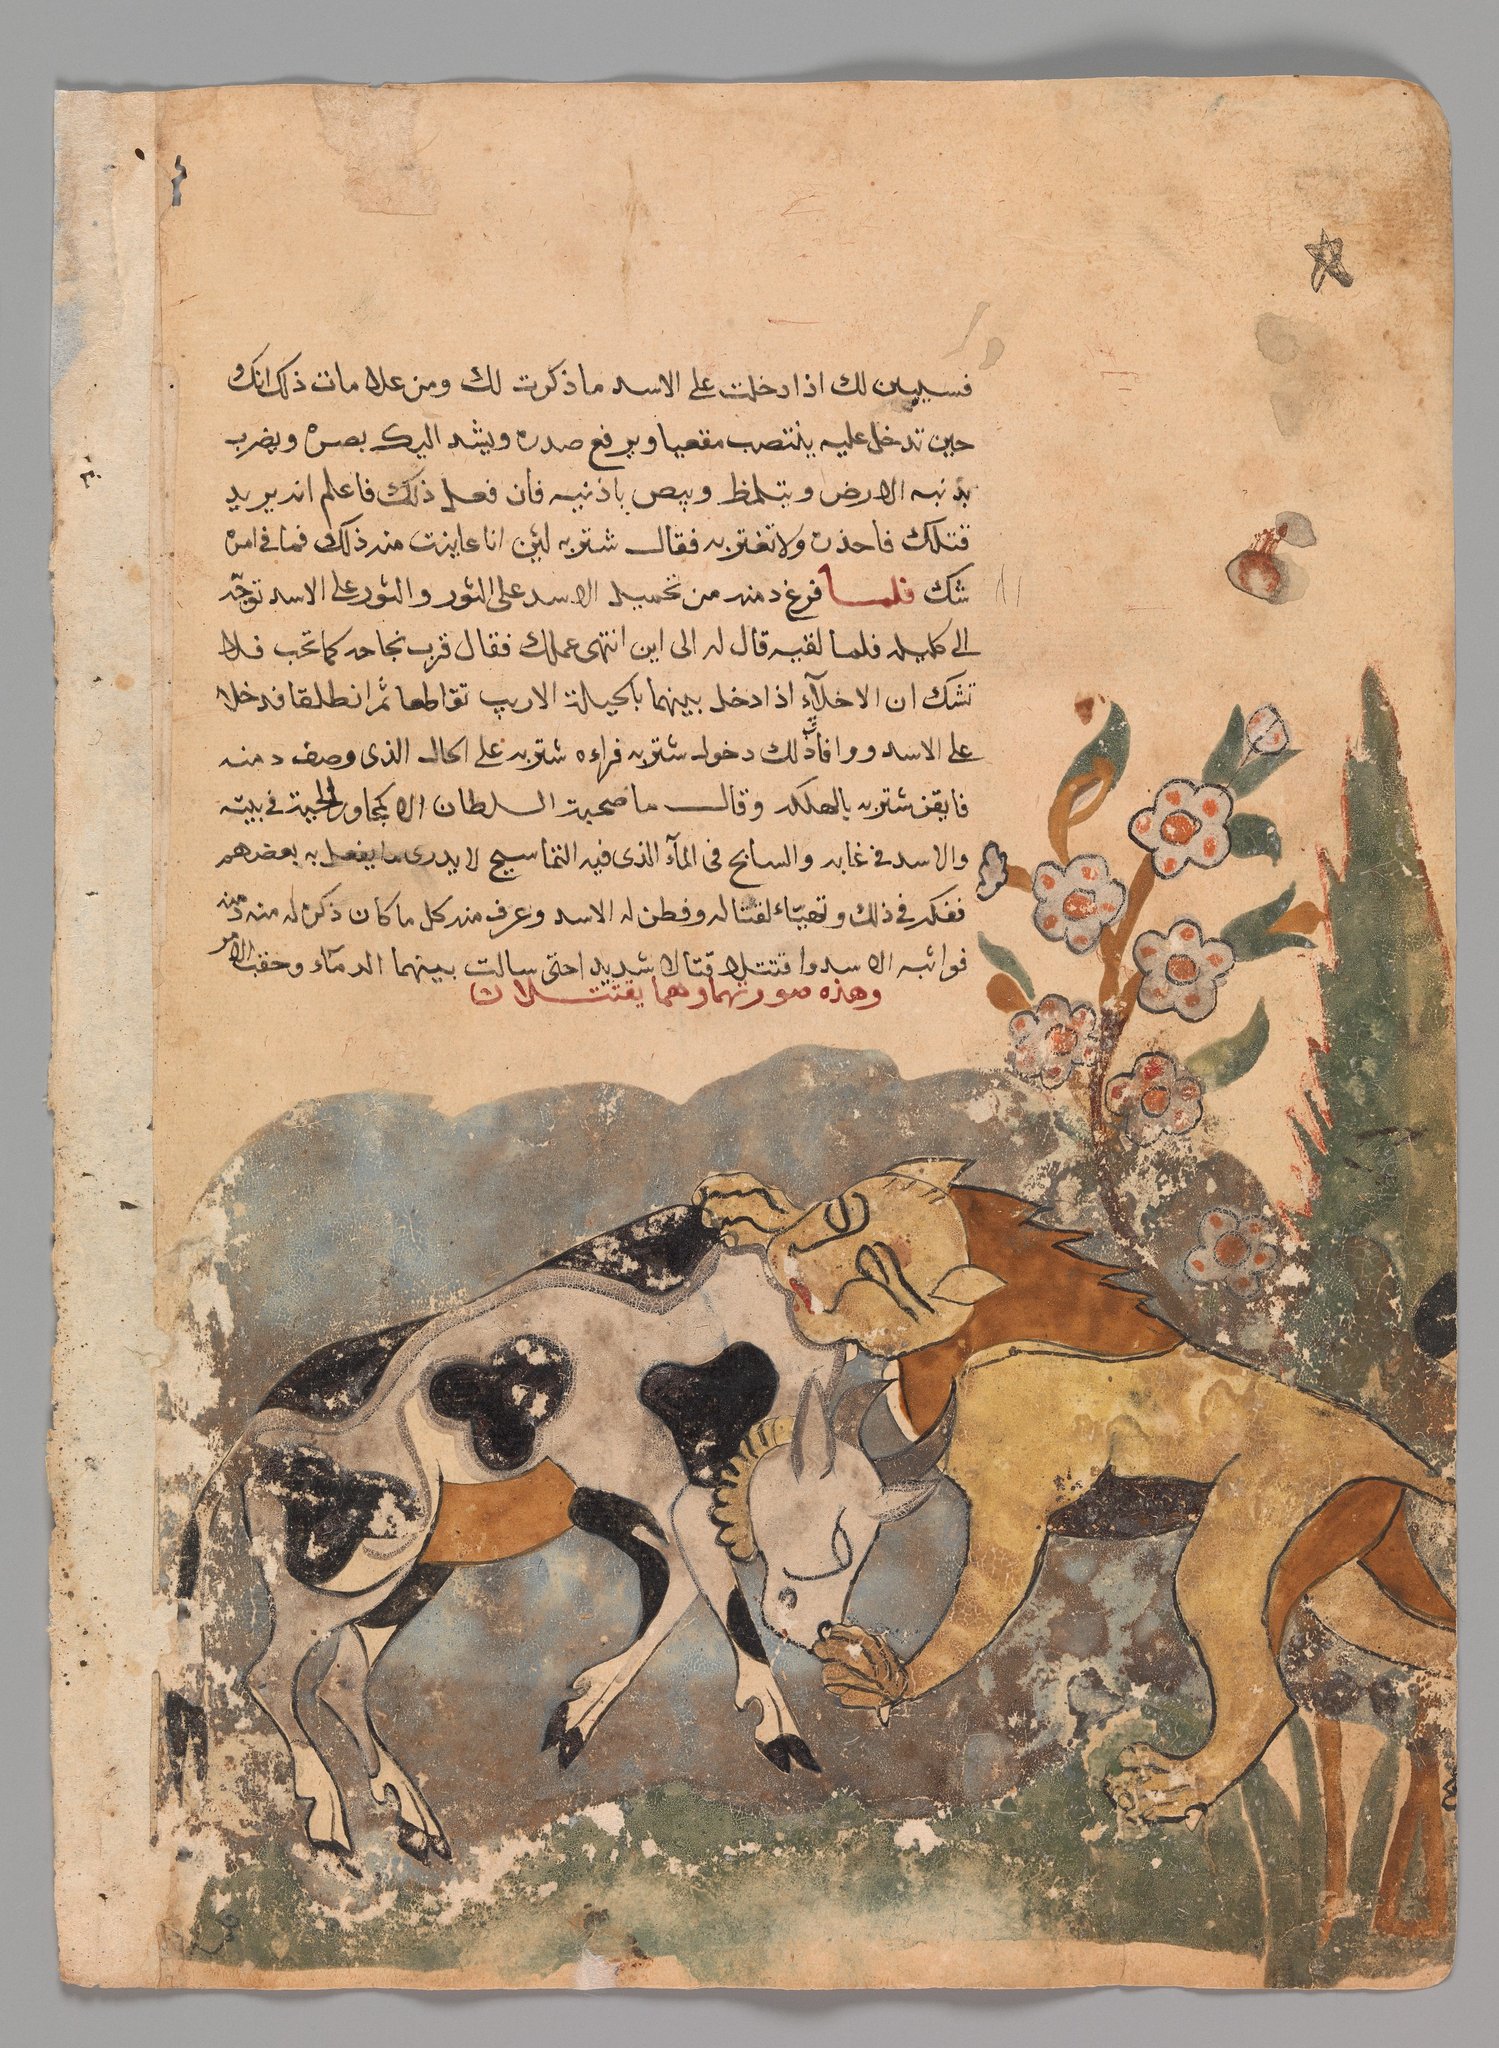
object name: folio from an illustrated manuscript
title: Folio from a Kalila wa Dimna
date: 1526-1550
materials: ink, paper, watercolor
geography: india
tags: cows,lions